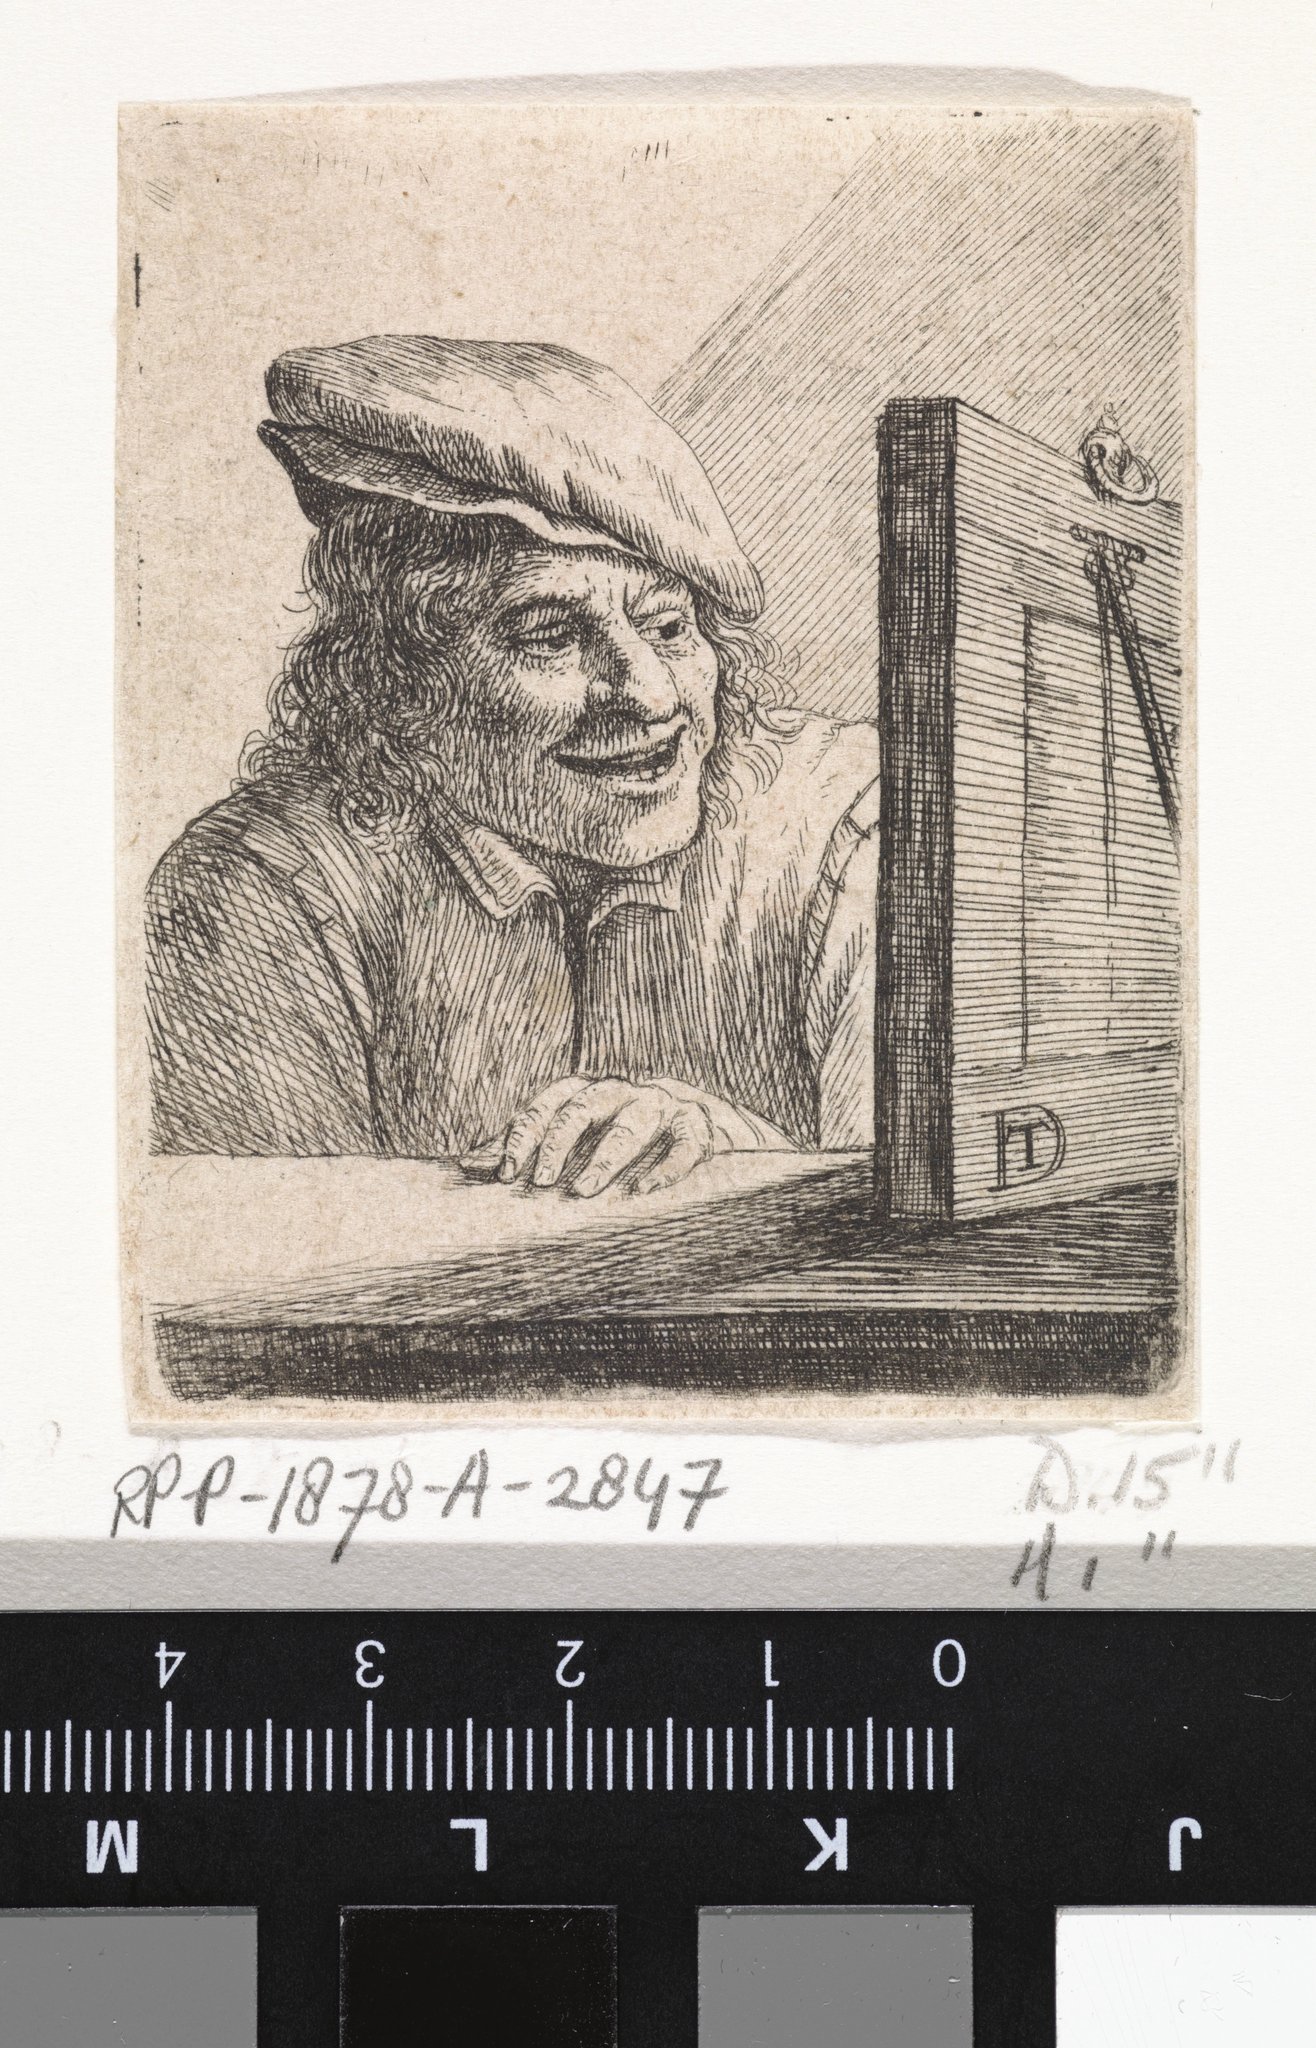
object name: print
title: De vijf zintuigen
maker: david teniers (ii)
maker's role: draughtsman, painter, print maker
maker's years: 1610-1690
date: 1626-1690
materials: paper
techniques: etching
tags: sight, looking (one of the five senses)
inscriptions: collector's mark: Lugt 2227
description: Een man kijkt in een spiegel. Personificatie van het gezicht. Prent maakt deel uit van een serie van de vijf zintuigen.